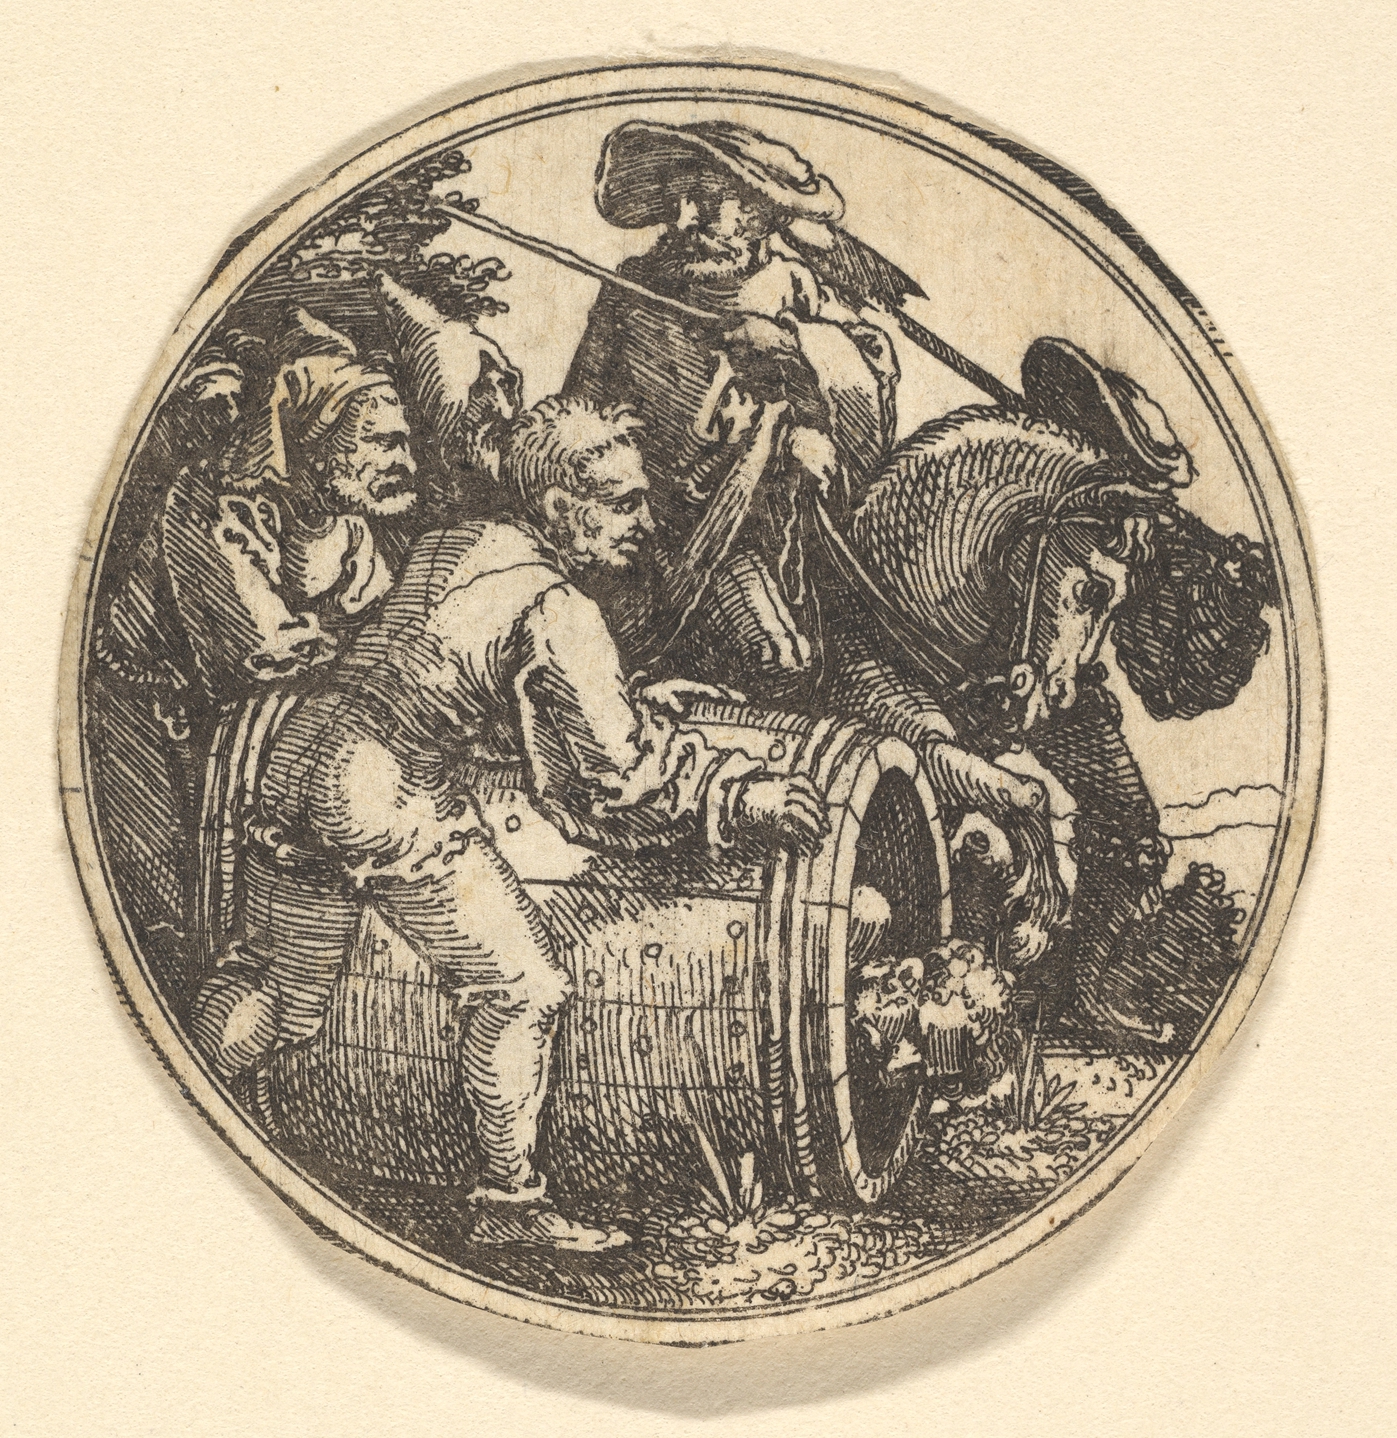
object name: print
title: Regulus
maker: sebald beham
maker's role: artist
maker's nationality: german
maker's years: 1500-1550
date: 1500-1550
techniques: etching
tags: men,horses